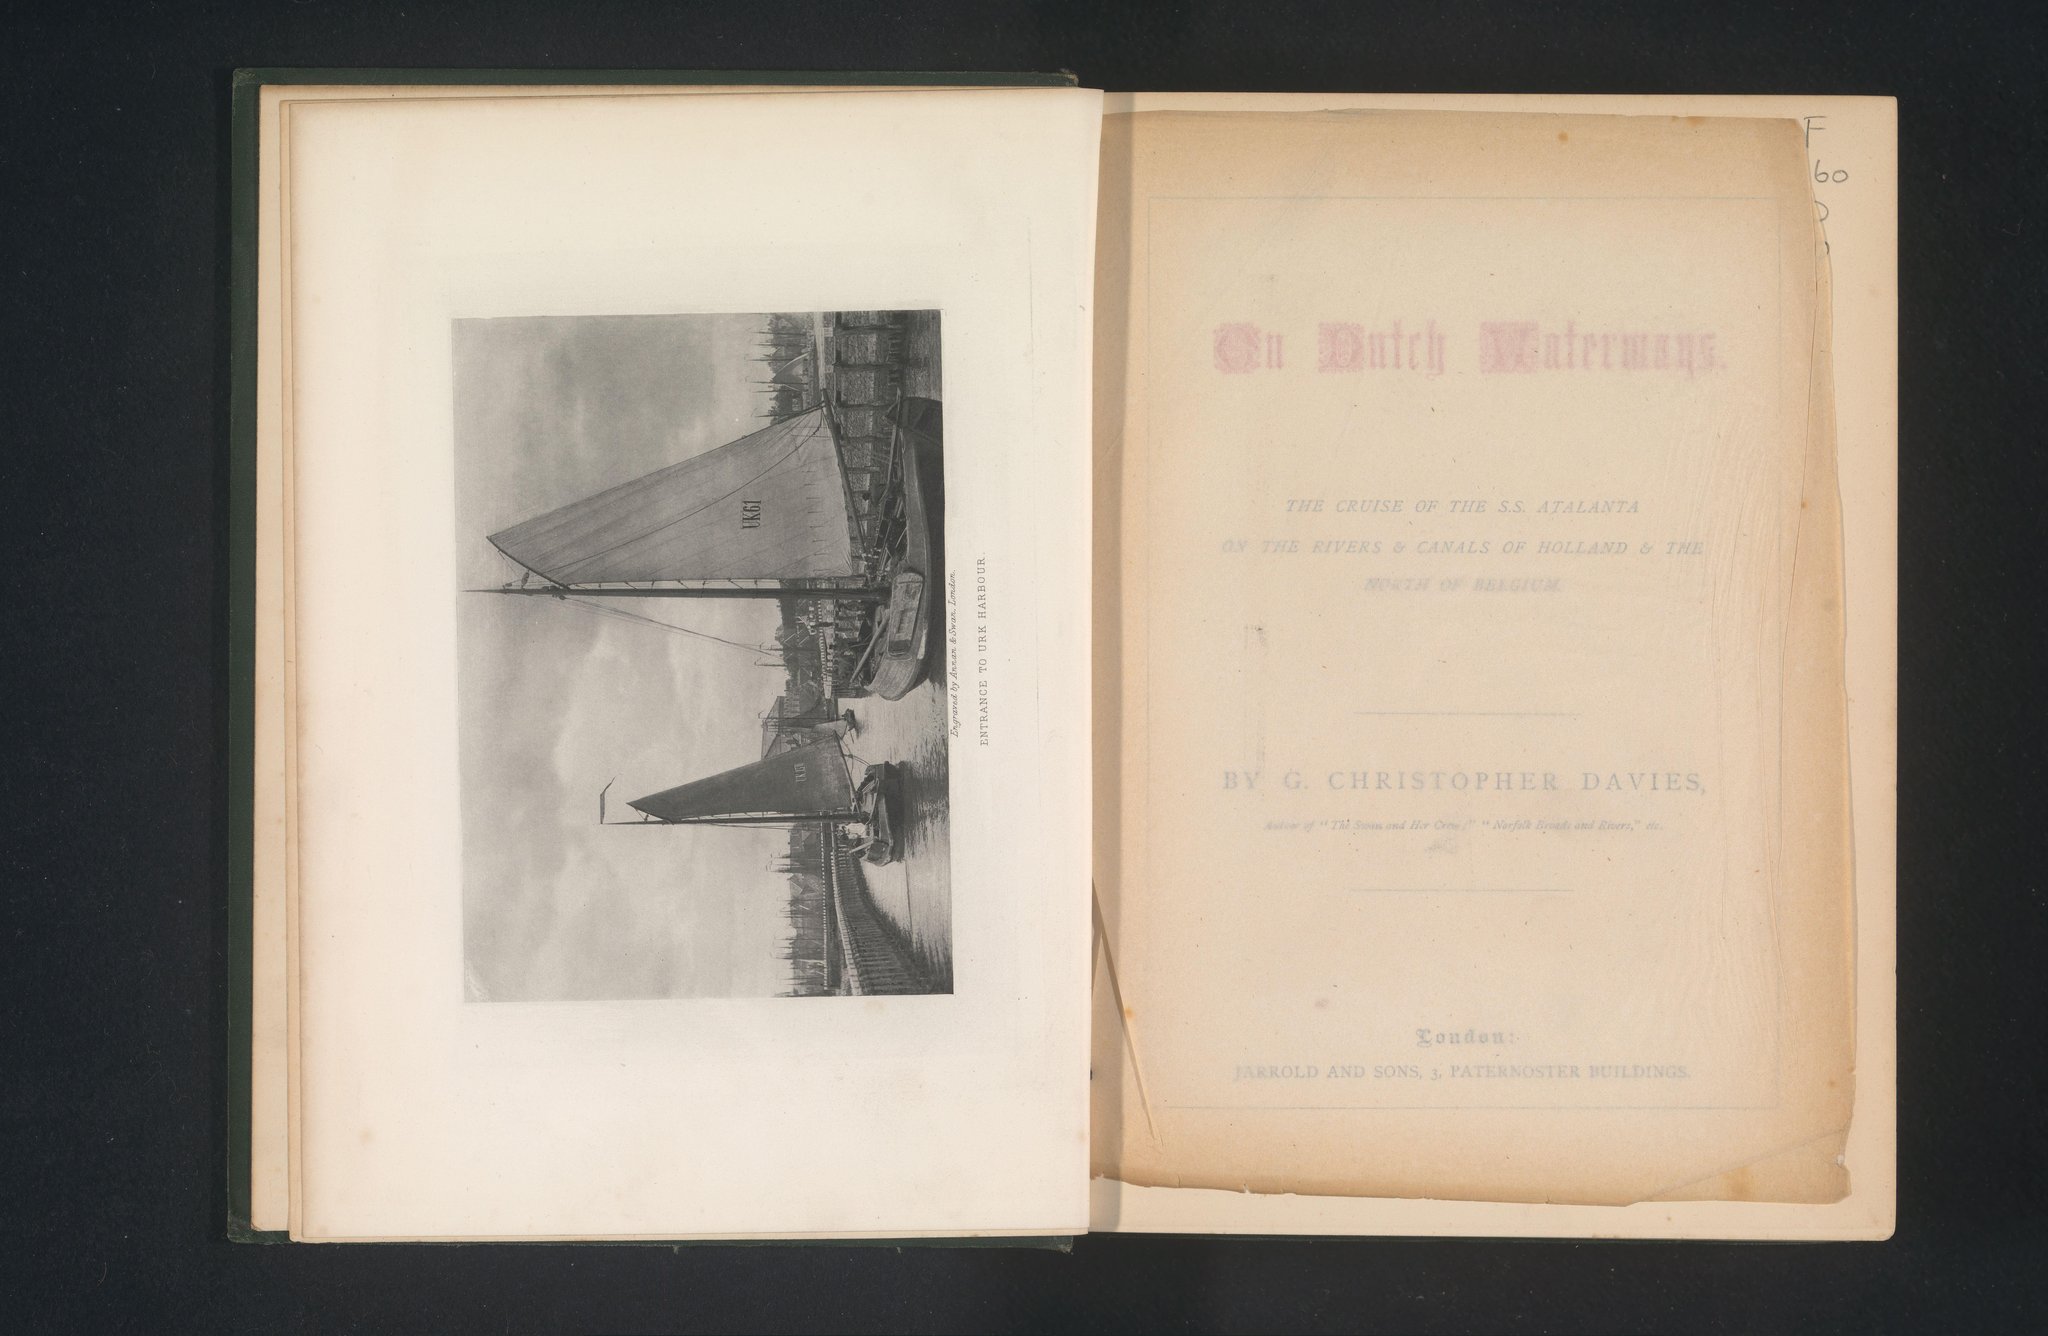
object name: photomechanical print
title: Gezicht op de ingang van de haven van Urk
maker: george christopher davies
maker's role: fotograaf, geoloog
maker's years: 1849-1922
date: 1881-1886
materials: paper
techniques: photoaquatint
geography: london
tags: harbour, sailing-ship, sailing-boat